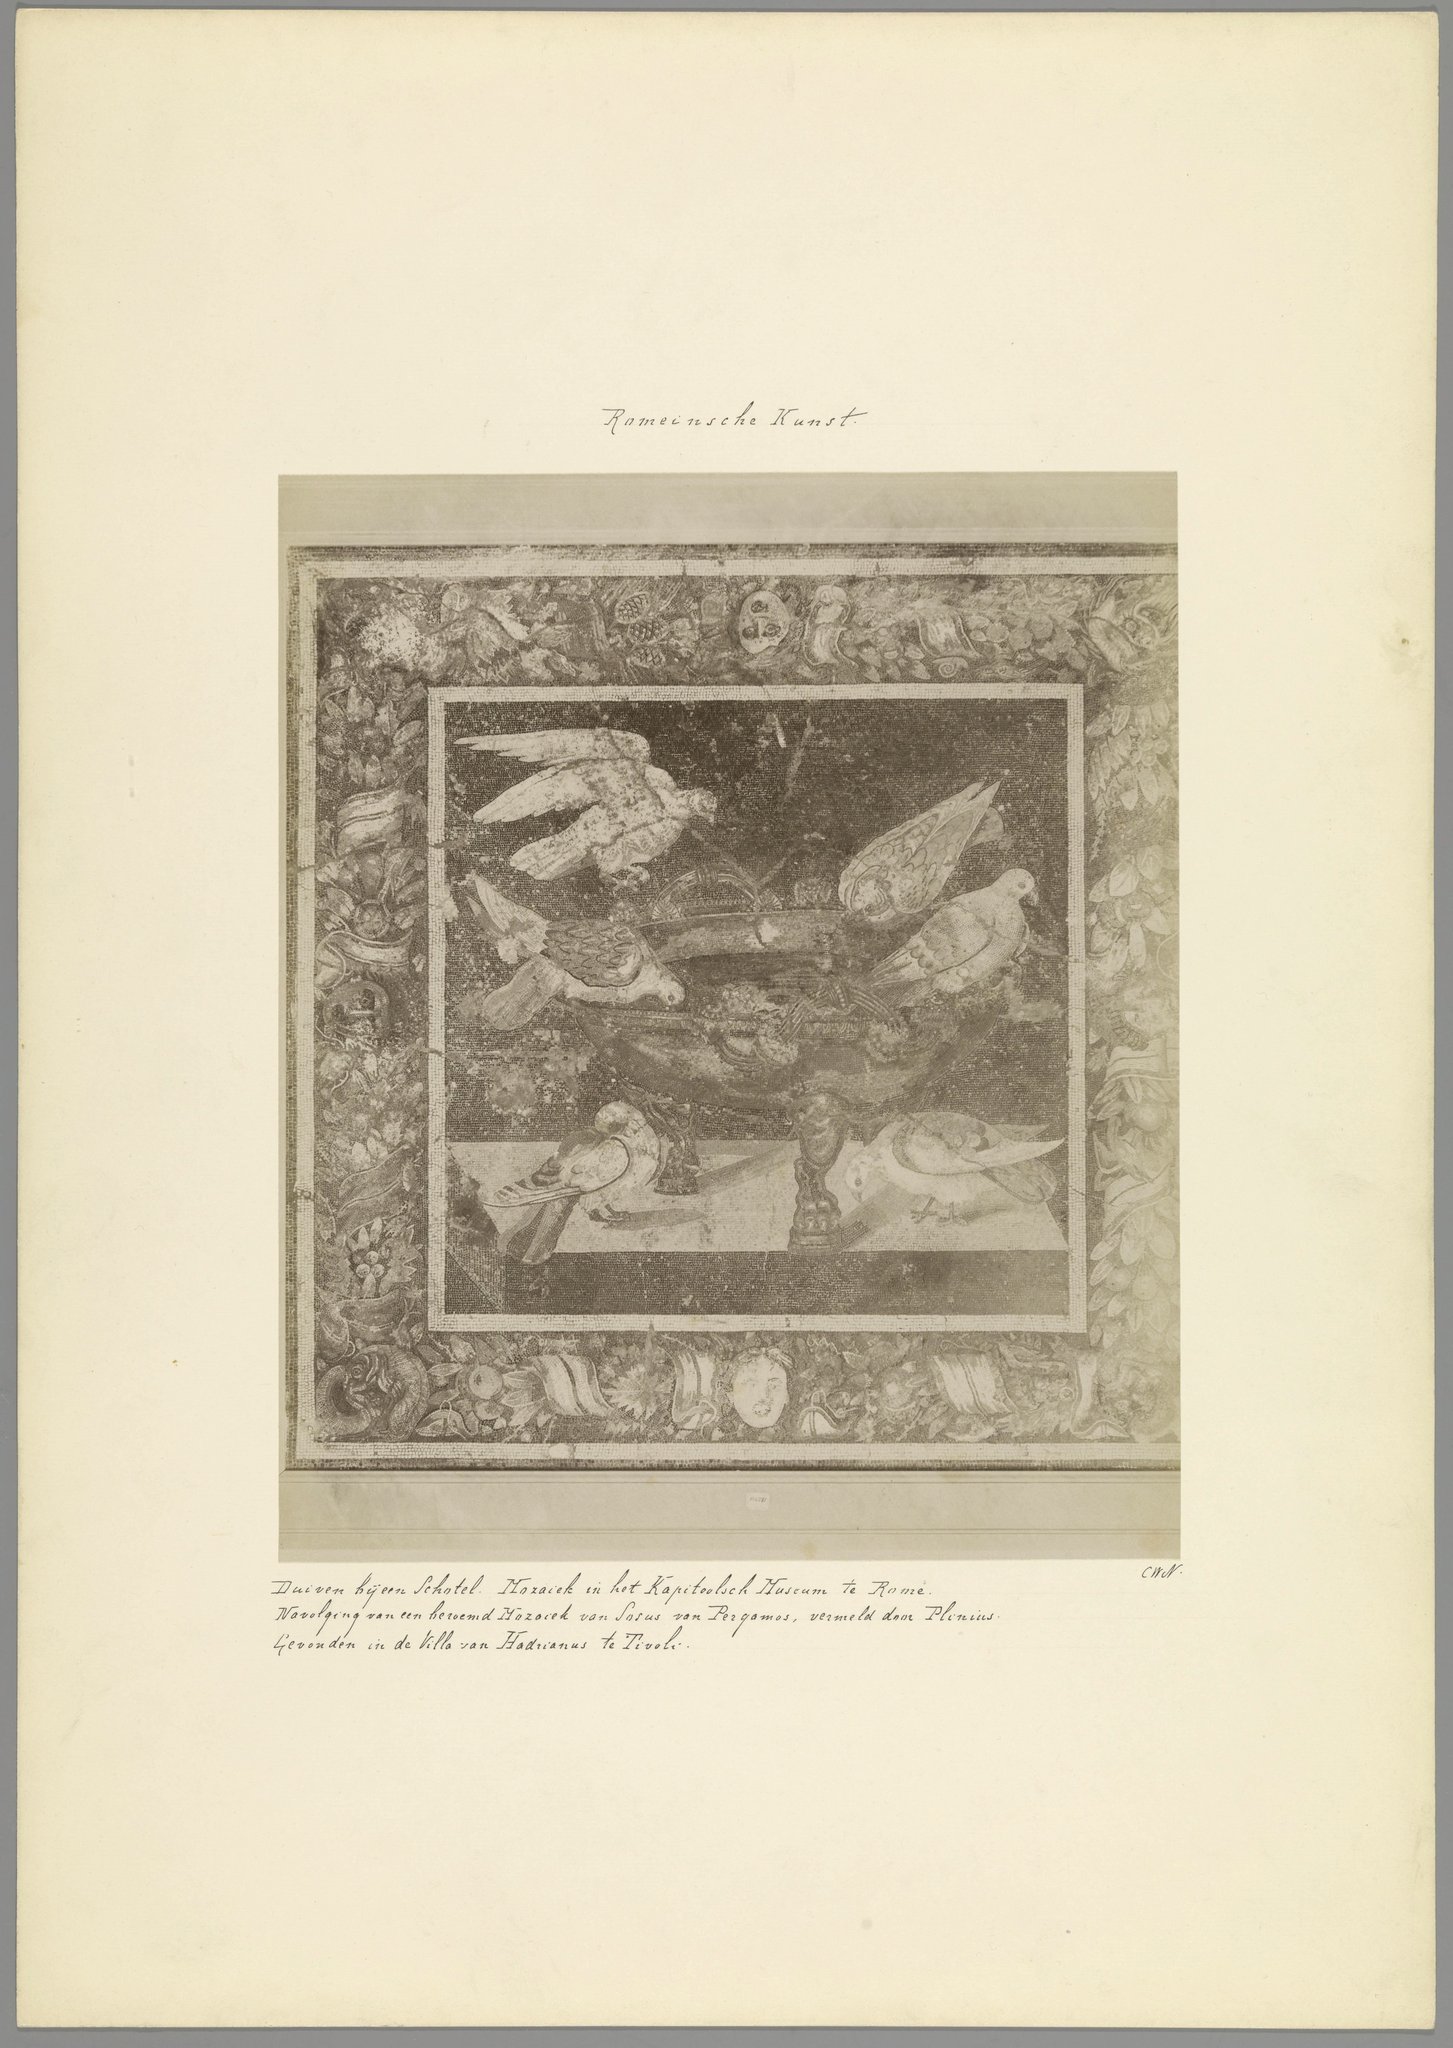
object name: photograph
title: Mozaïek met duiven rond een waterschaal, afkomstig uit Pompeï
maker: Anonymous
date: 1875-1900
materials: cardboard, photographic support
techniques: albumen print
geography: naples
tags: mask, fruits and vegetables ~ ornament, art (+ mosaic making), bowl, doves, pigeons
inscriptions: inscription: ‘CWN.’, collector's mark: ‘INSTITUUT VOOR KUNST-NIJVERHEIDSONDERWIJS GABRIËL METSUSTRAAT No. 16. AMSTERDAM’, collector's mark: ‘KUNSTNIJVERHEIDSCHOOL QUELLINUS AMSTERDAM FRANS HALSSTRAAT 14.’, inscription: ‘Romeinsche Kunst. Duiven bij een Schotel. Mozaïek in het Kapitoolsch Museum te Rome. Navolging van een beroemd Mozaiek van Sosus van Pergamos, vermeld door Plinius. Gevonden in de Villa van Hadrianus te Tivoli.’